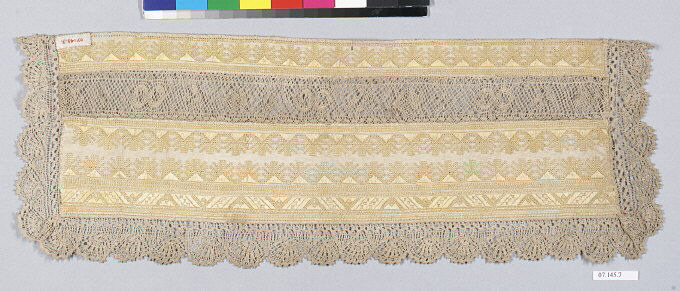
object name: cuff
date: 1800-1899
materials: linen, silk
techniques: lace